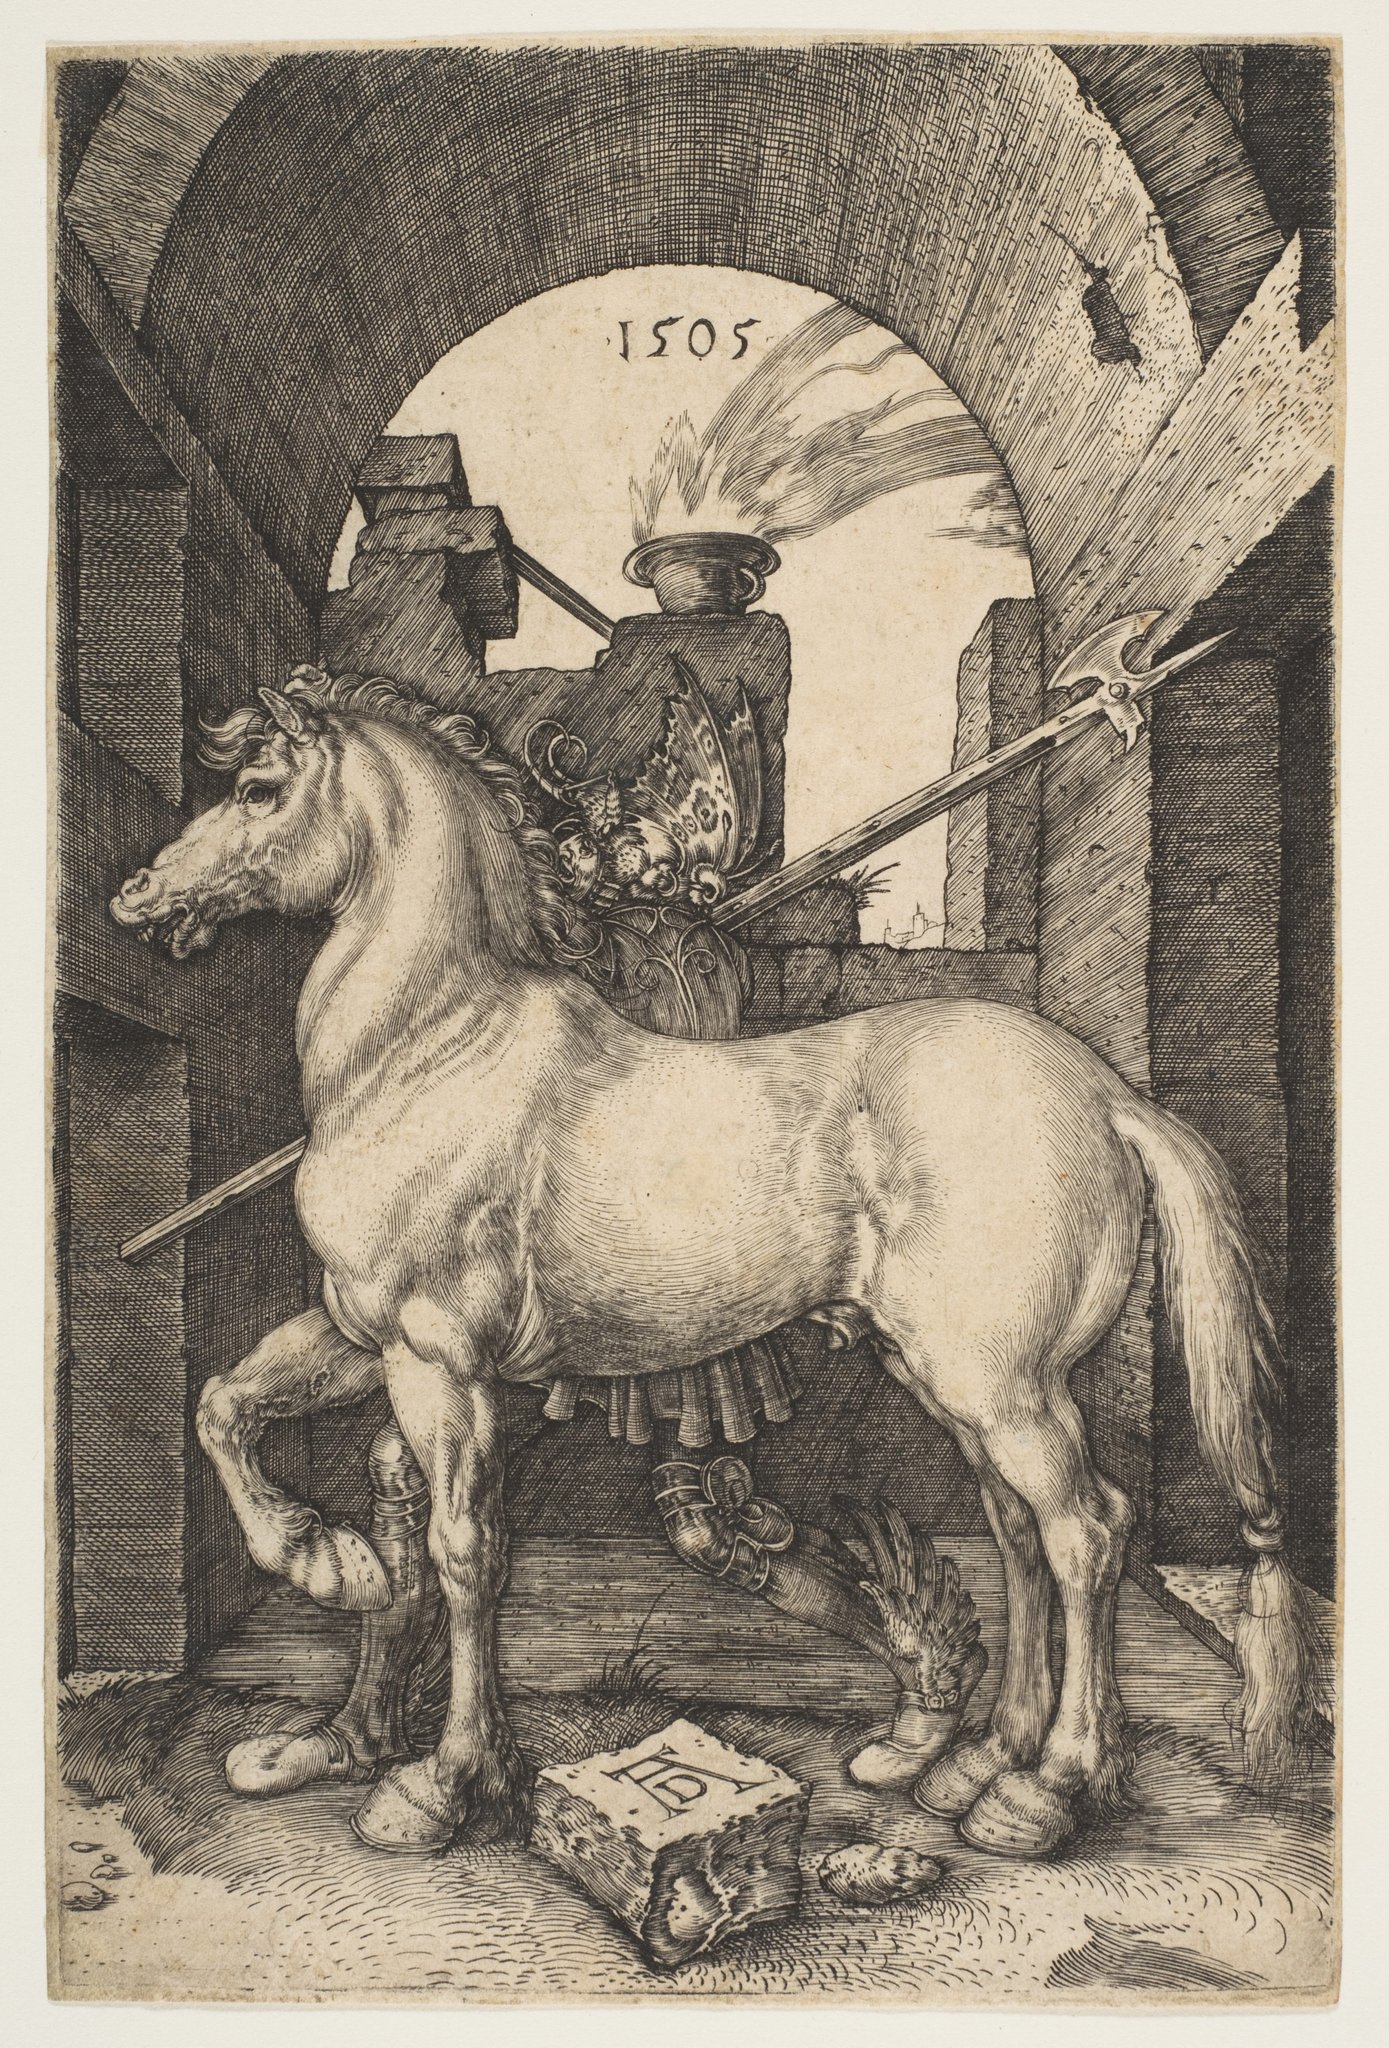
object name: print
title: The Little Horse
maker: albrecht dürer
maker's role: artist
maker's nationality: german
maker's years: 1471-1528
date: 1505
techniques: engraving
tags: weapons,horses